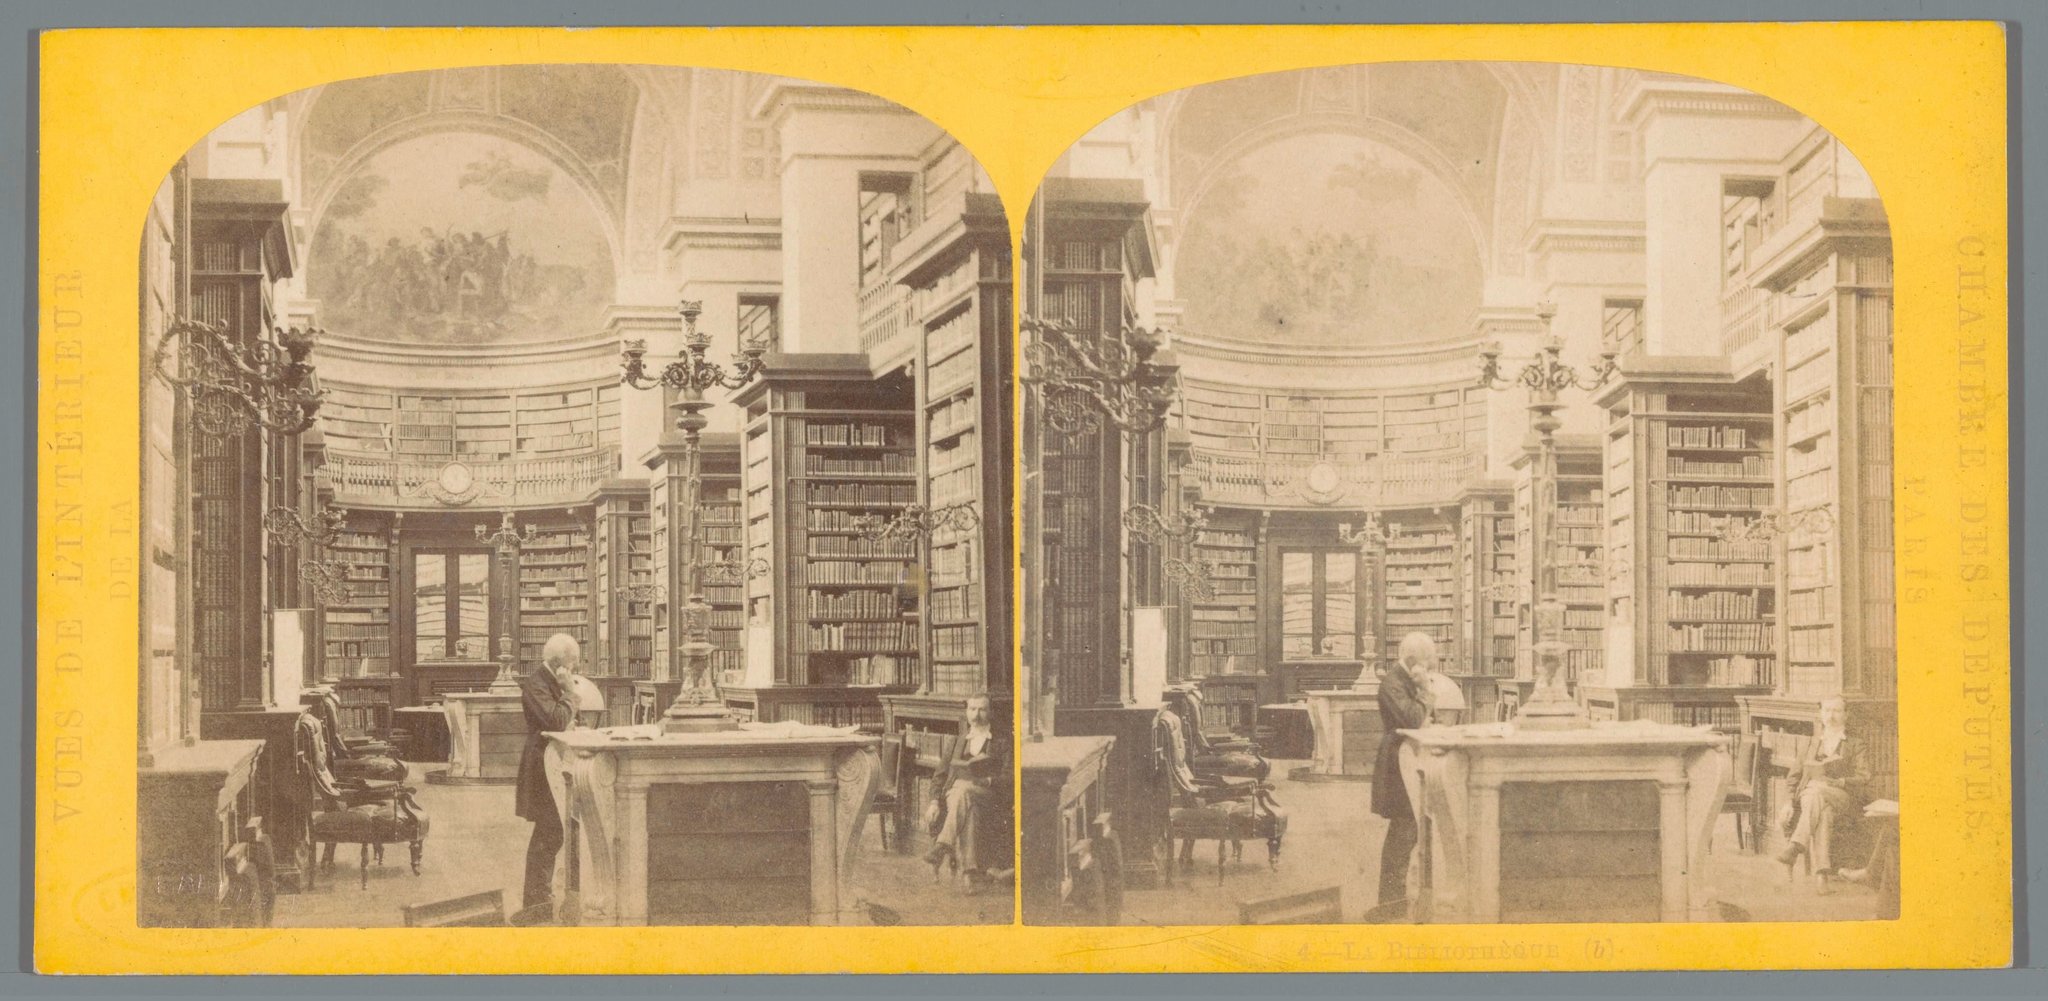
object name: stereograph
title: Chambre des Deputés, Paris La Bibliotheque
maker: charles gaudin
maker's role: publisher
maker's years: 1825-1905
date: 1850-1880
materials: cardboard, photographic support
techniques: albumen print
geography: palais bourbon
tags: study; 'studiolo'; library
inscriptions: number: ‘4.’